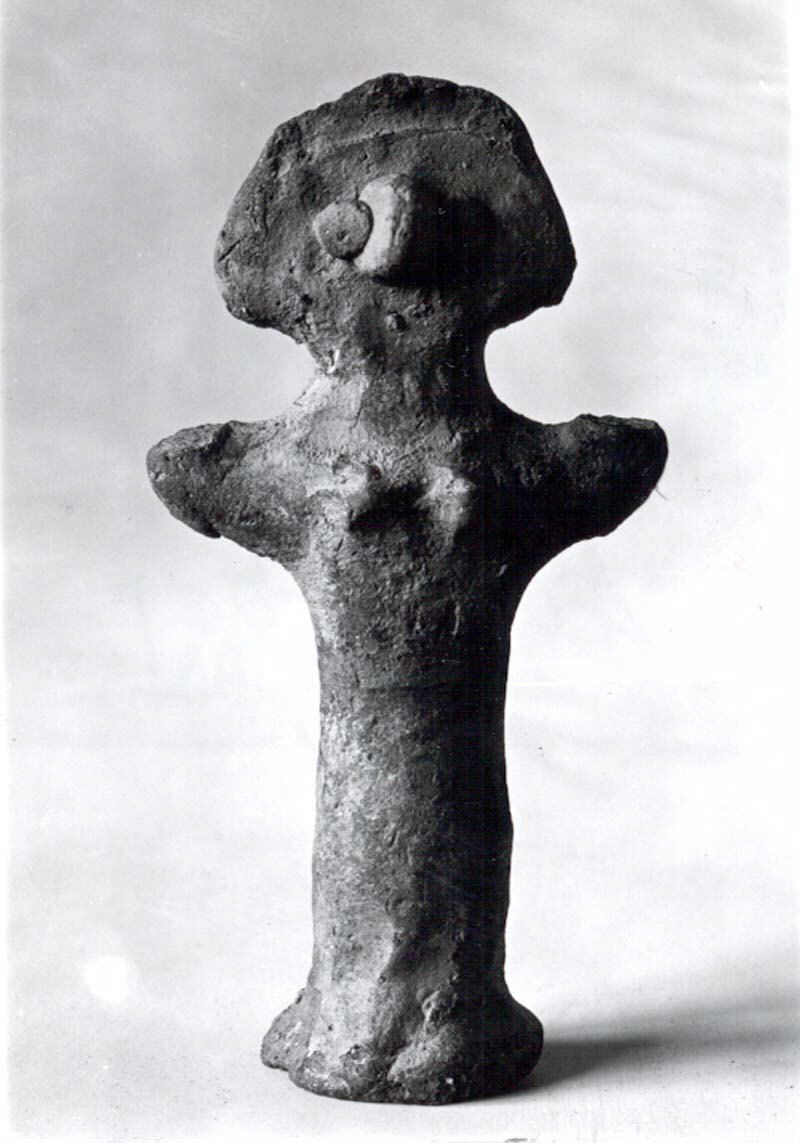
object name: sculpture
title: Figure of a woman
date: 2000-1 BCE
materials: ceramic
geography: syria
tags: women